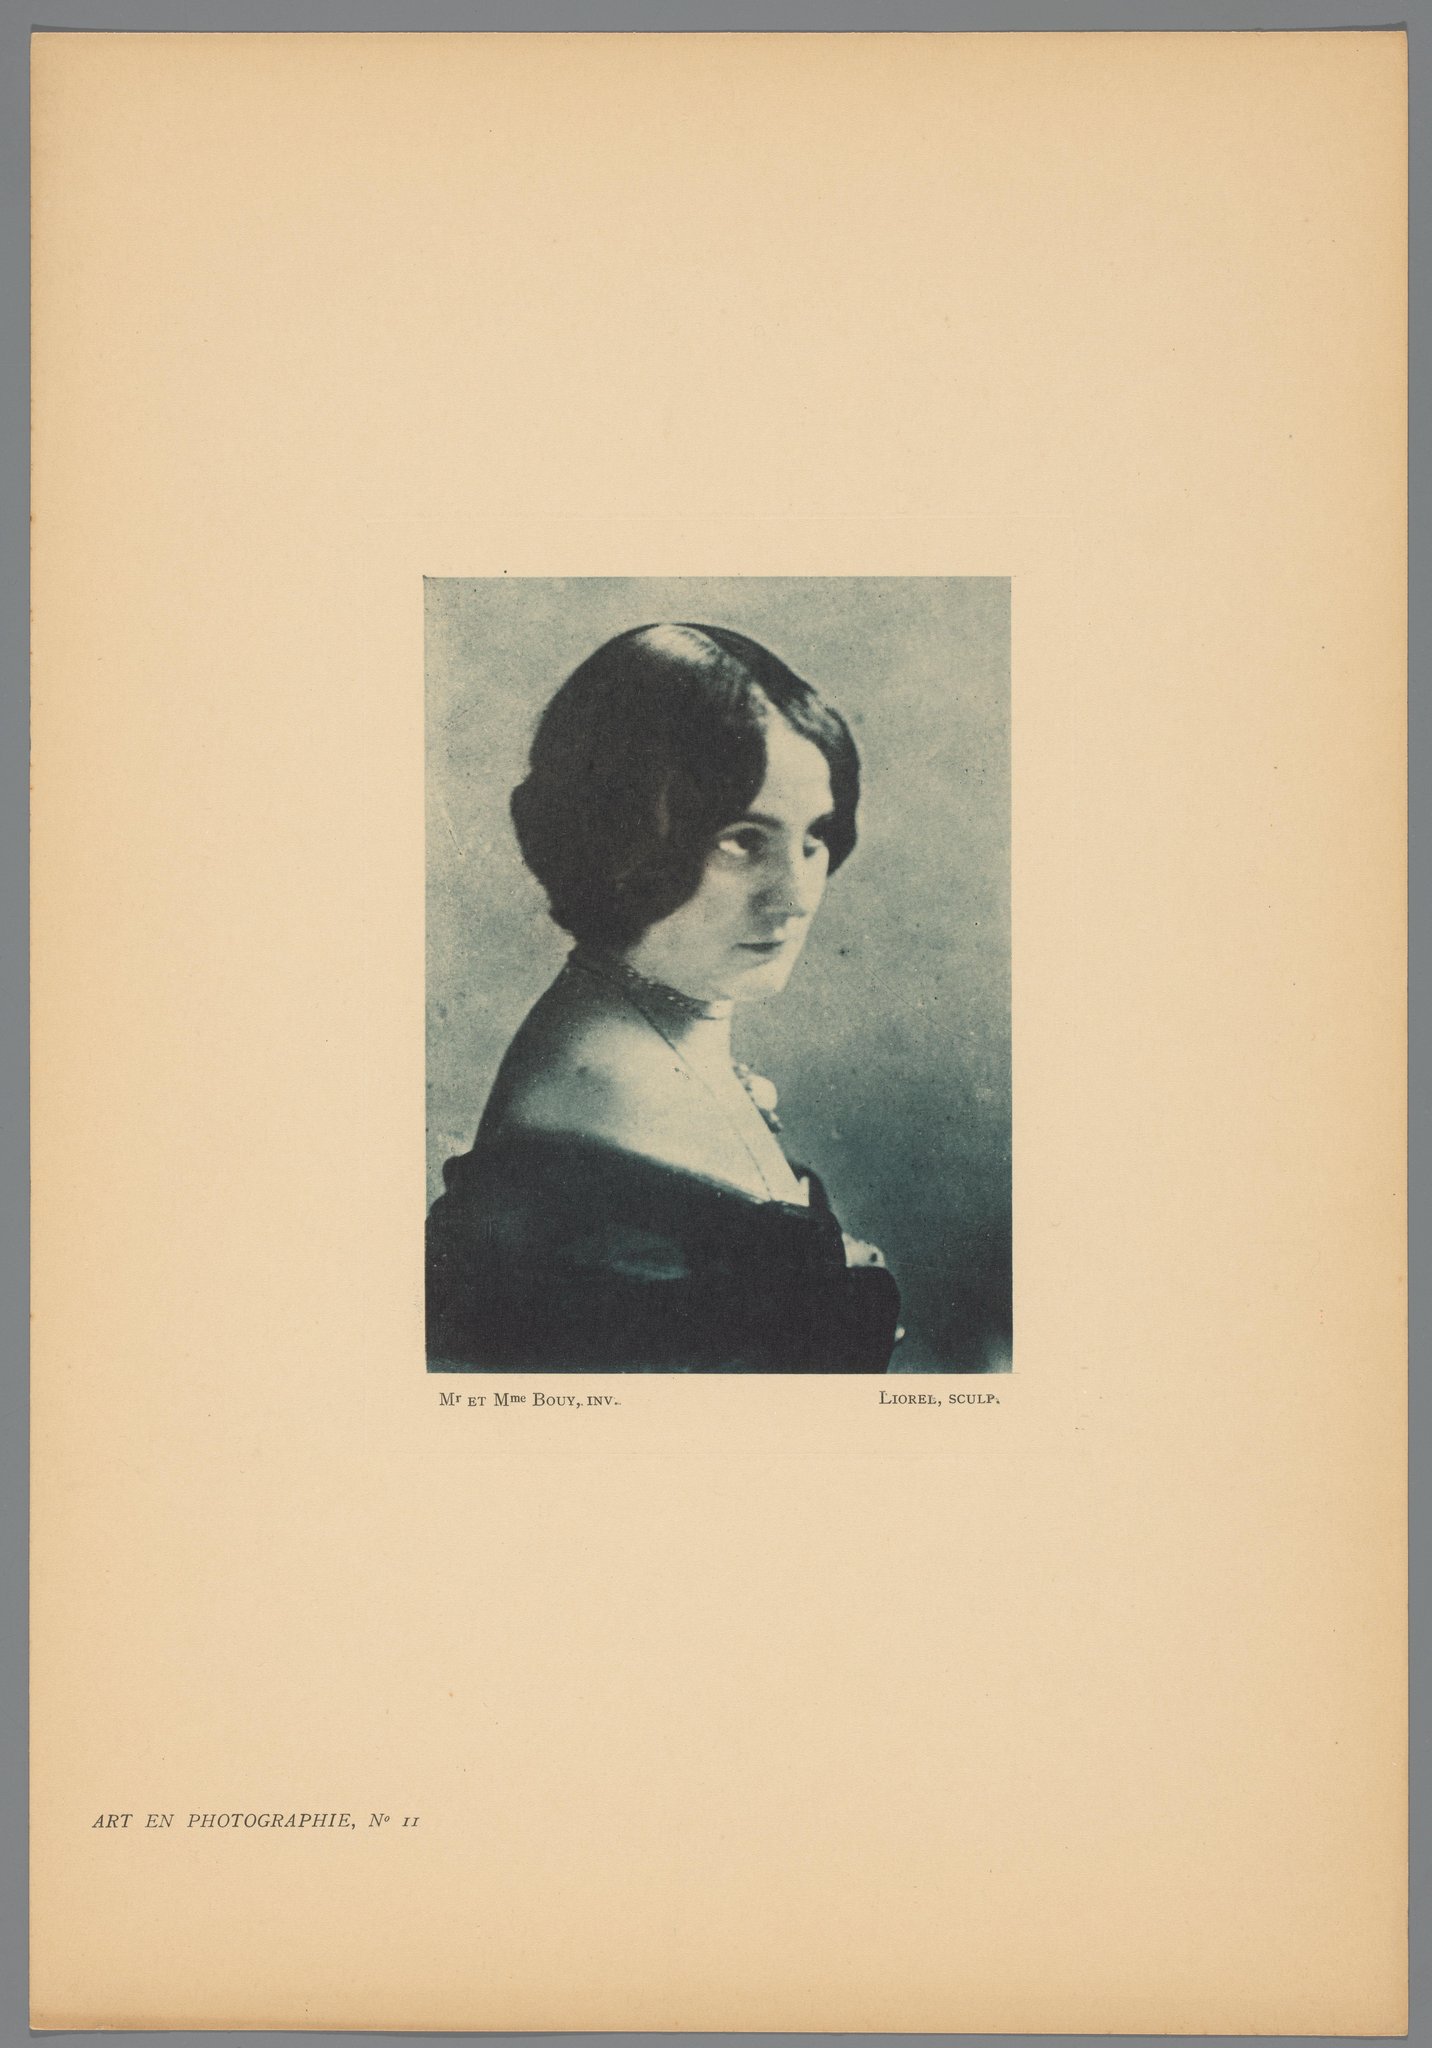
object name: photomechanical print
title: Portret van een onbekende vrouw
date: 1896-1901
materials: paper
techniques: photograph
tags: historical persons - bb - woman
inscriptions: inscription: ‘ART EN PHOTOGRAPHIE, No 11’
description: Deze prent maakt deel uit van een omslag met 54 prenten op 52 bladen.